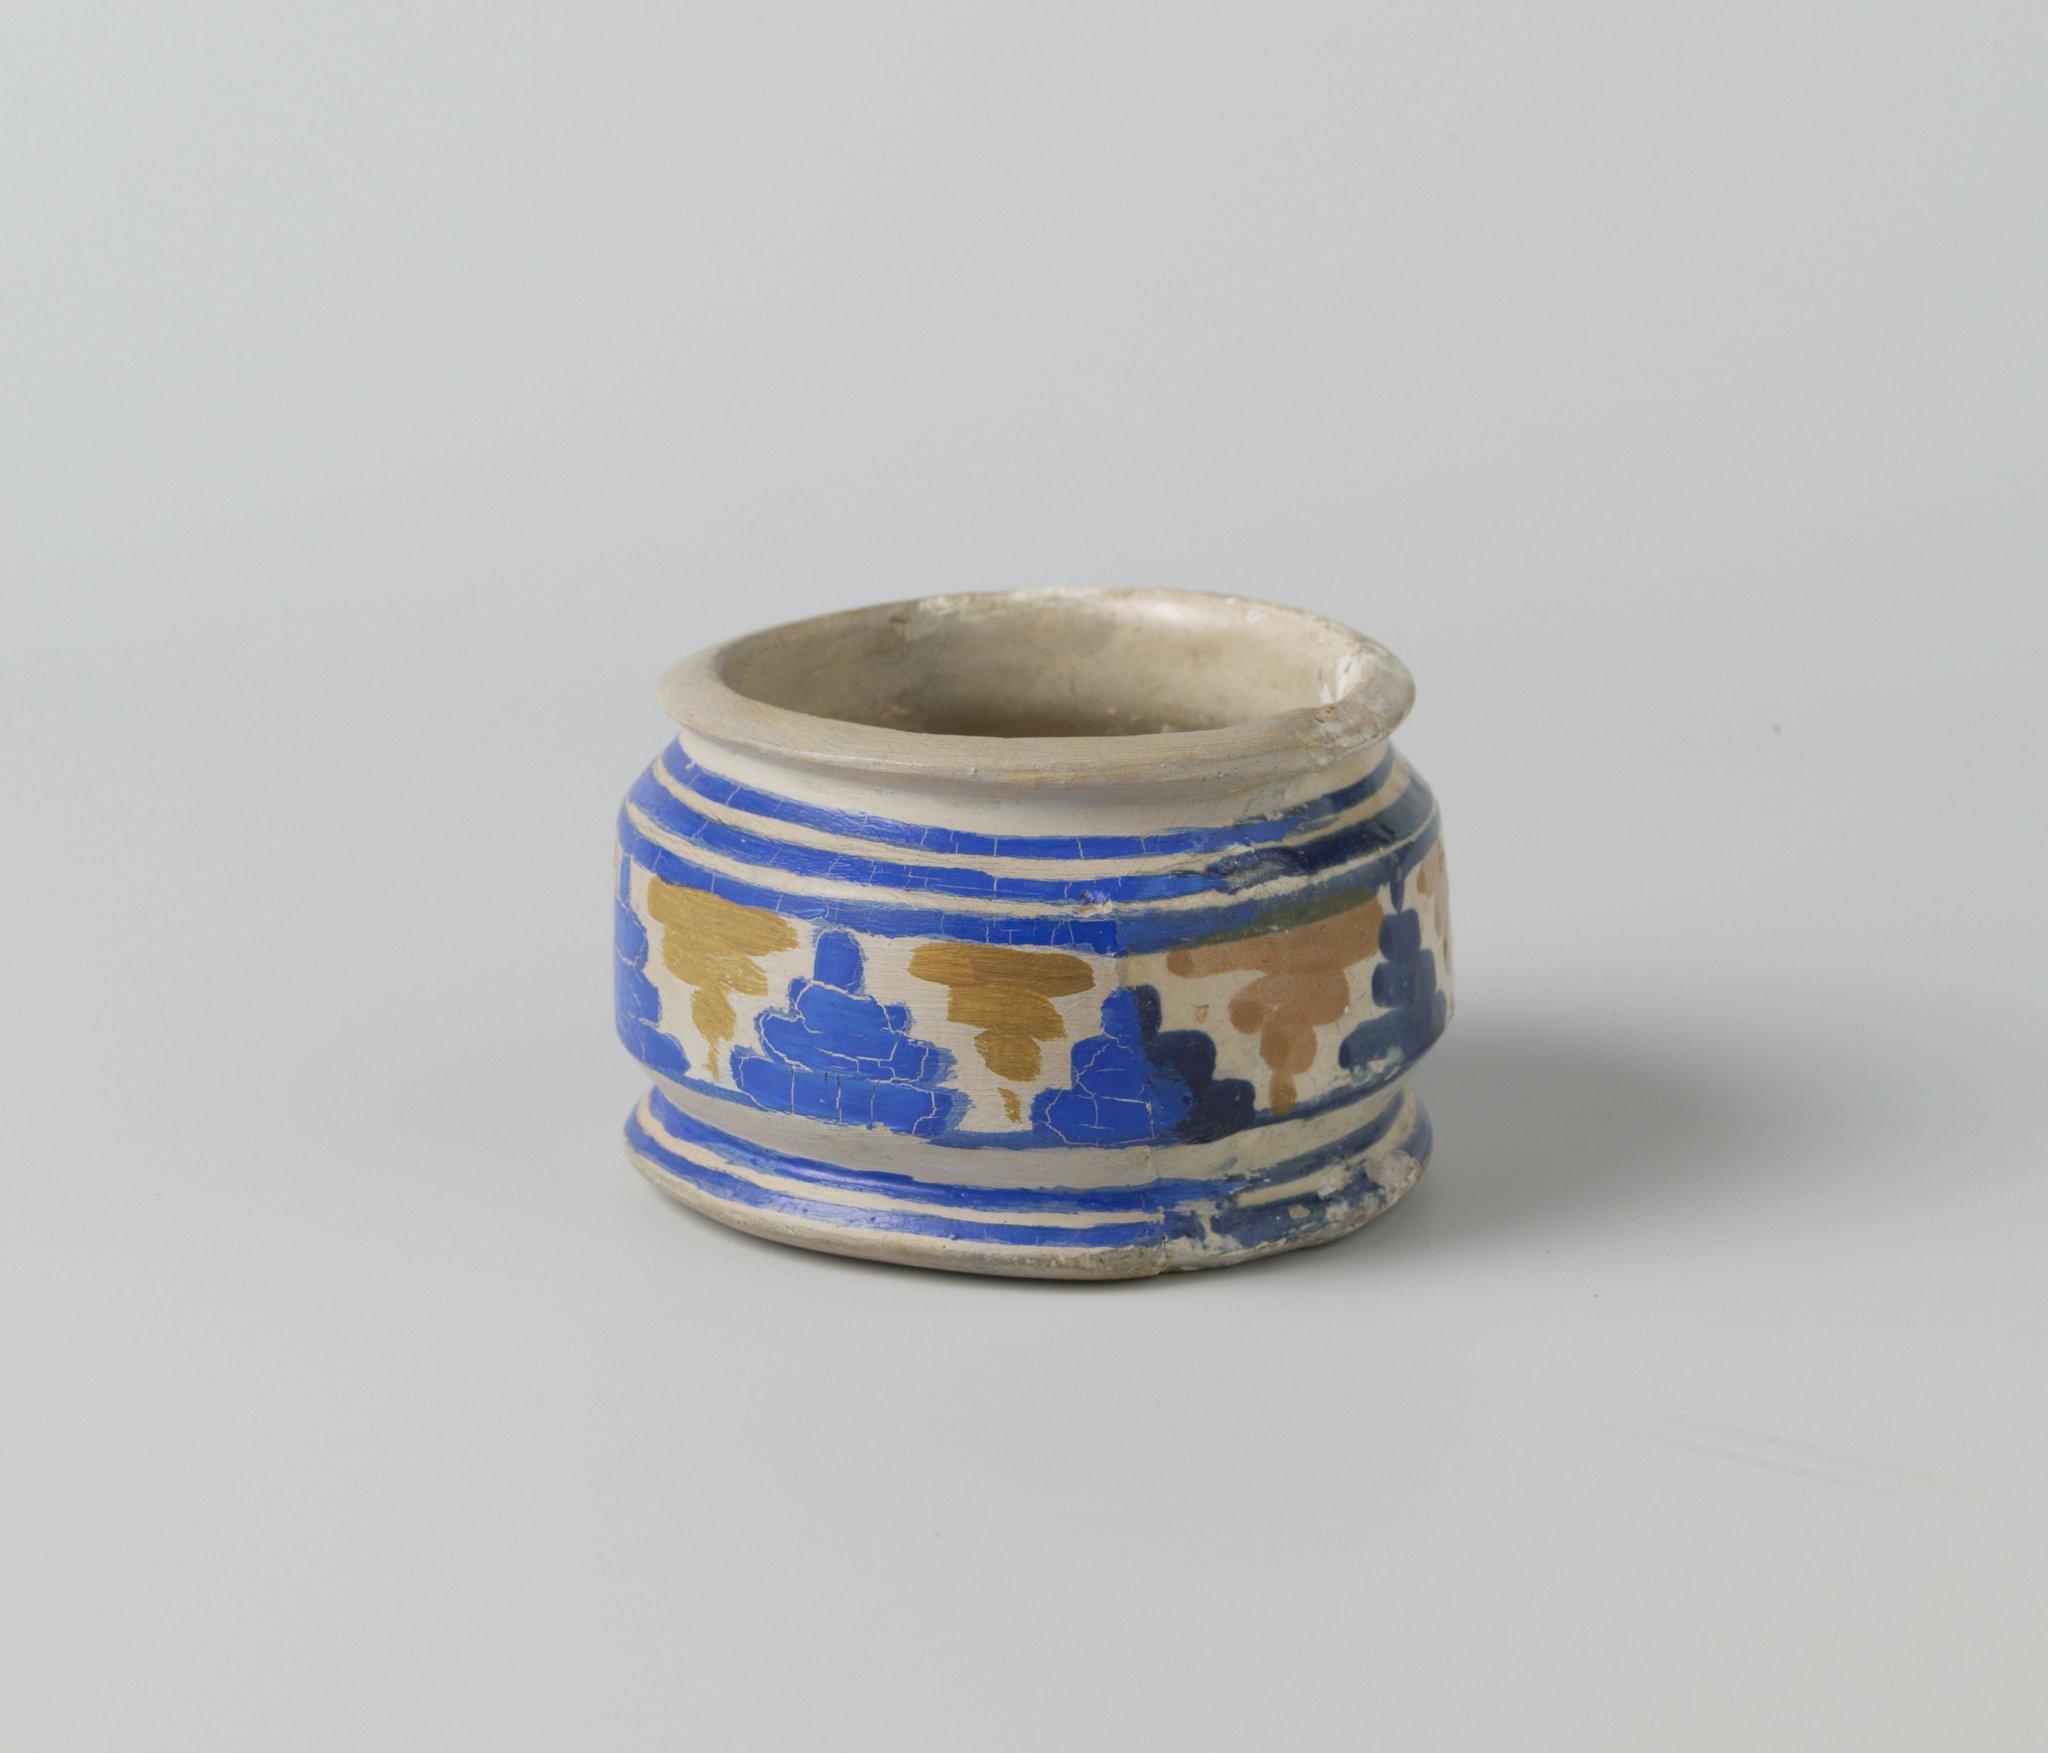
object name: ointment vessel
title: Zalfpot, beschilderd met geometrische ornamenten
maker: Anonymous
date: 1575-1620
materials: earthenware, glaze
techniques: maiolica, painted, polychromy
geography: netherlands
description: Lage, cilindrische zalfpot van veelkleurig beschilderde majolica. De pot heeft een ingeknepen voet en bovenrand en is beschilderd met geometrische ornamenten in blauw en oranje.